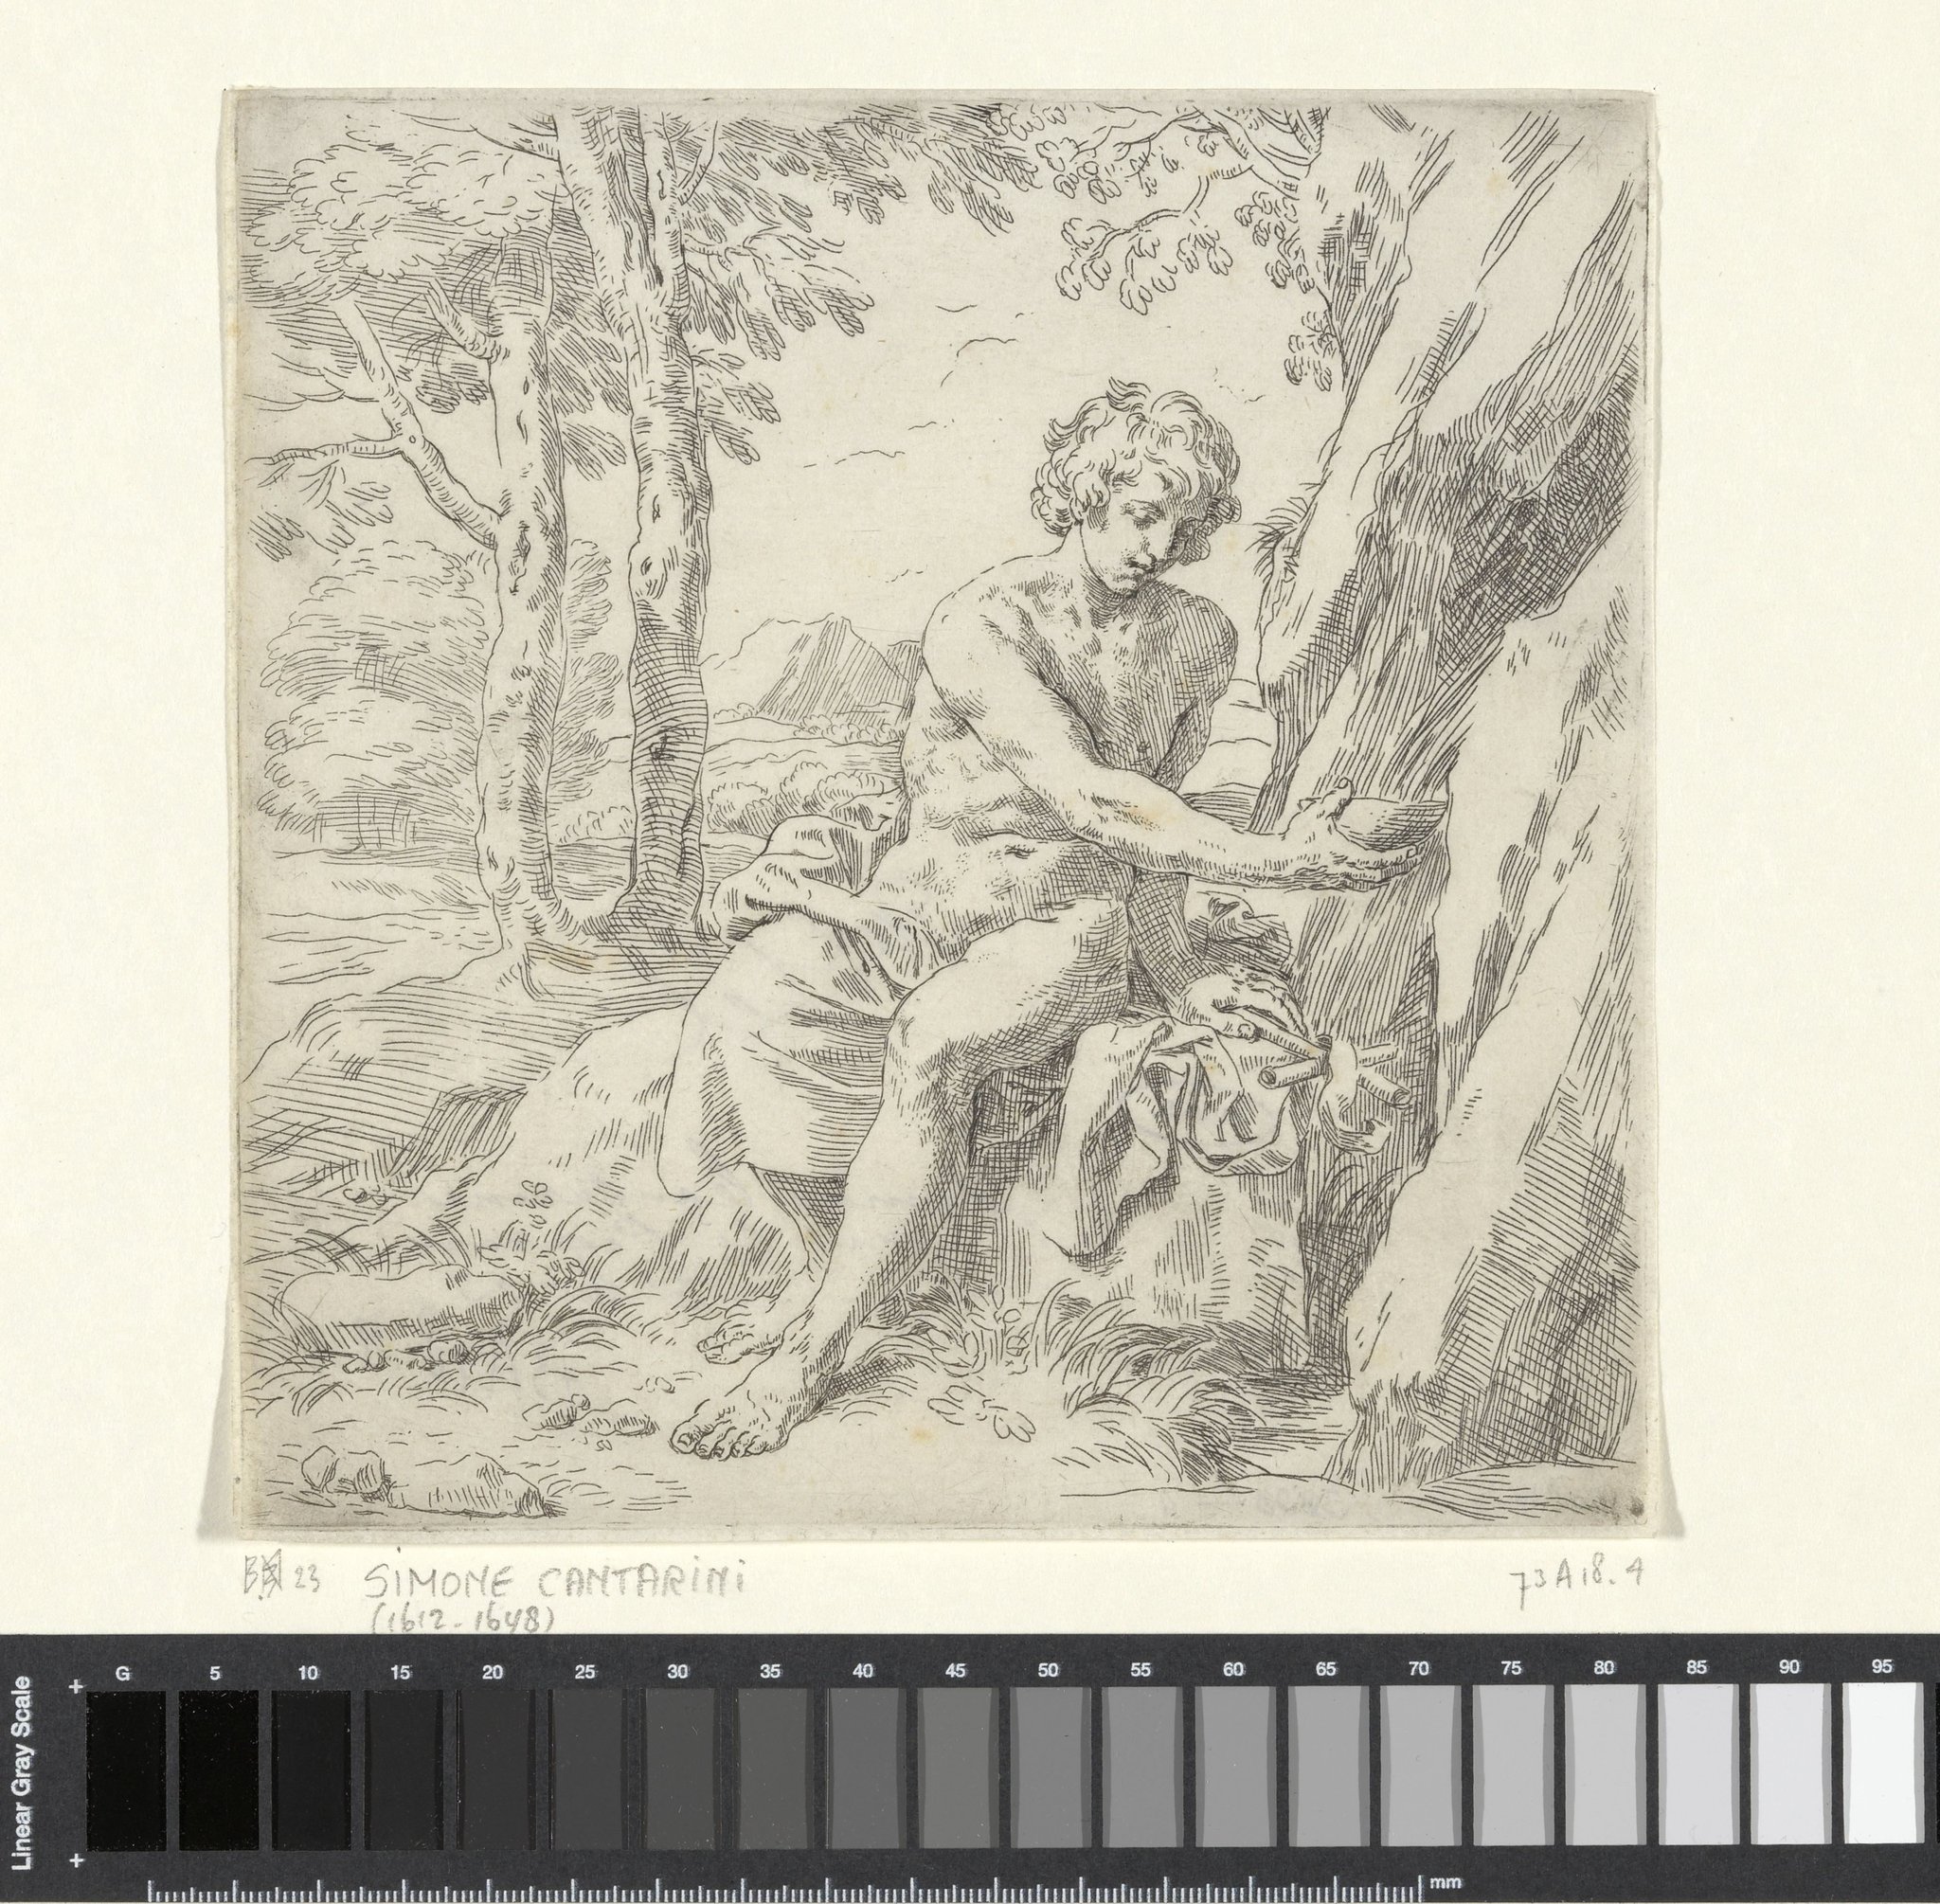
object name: print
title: Johannes de Doper in de wildernis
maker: simone cantarini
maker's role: draughtsman, print maker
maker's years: 1612-1648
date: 1622-1648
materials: paper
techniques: etching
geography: italy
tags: john the baptist in the wilderness, usually accompanied by a lamb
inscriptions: collector's mark: Lugt 2228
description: Johannes de Doper zit bij een waterbron in een landschap. Hij vangt water op met een kom.